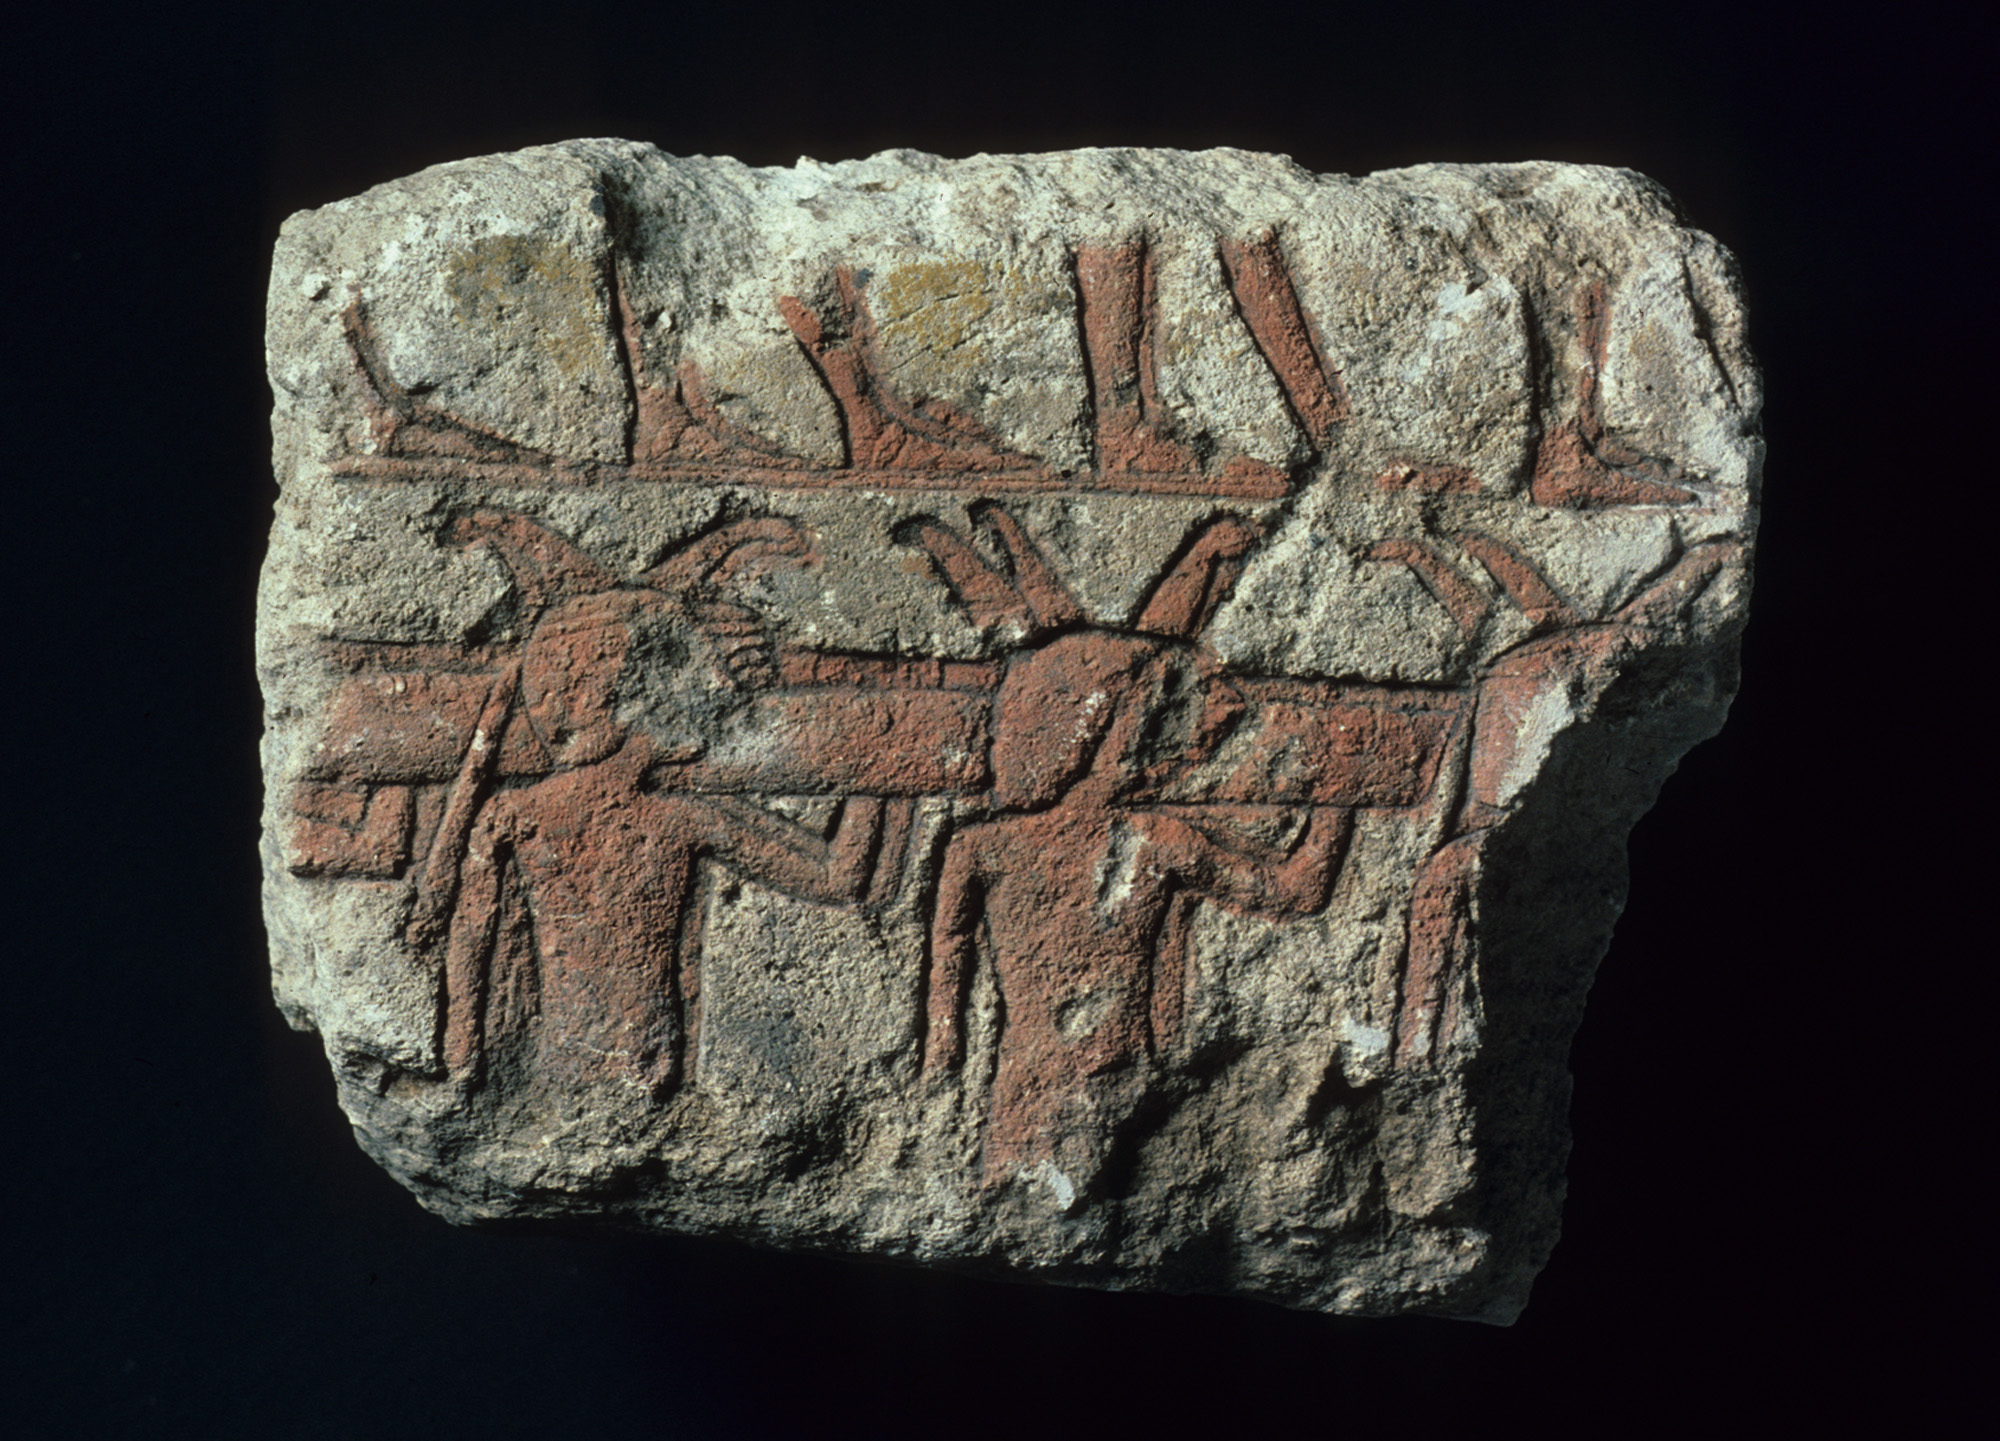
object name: talatat, foreign soldier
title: Relief with foreign soldiers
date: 1353-1336 BCE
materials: limestone, paint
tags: soldiers,men